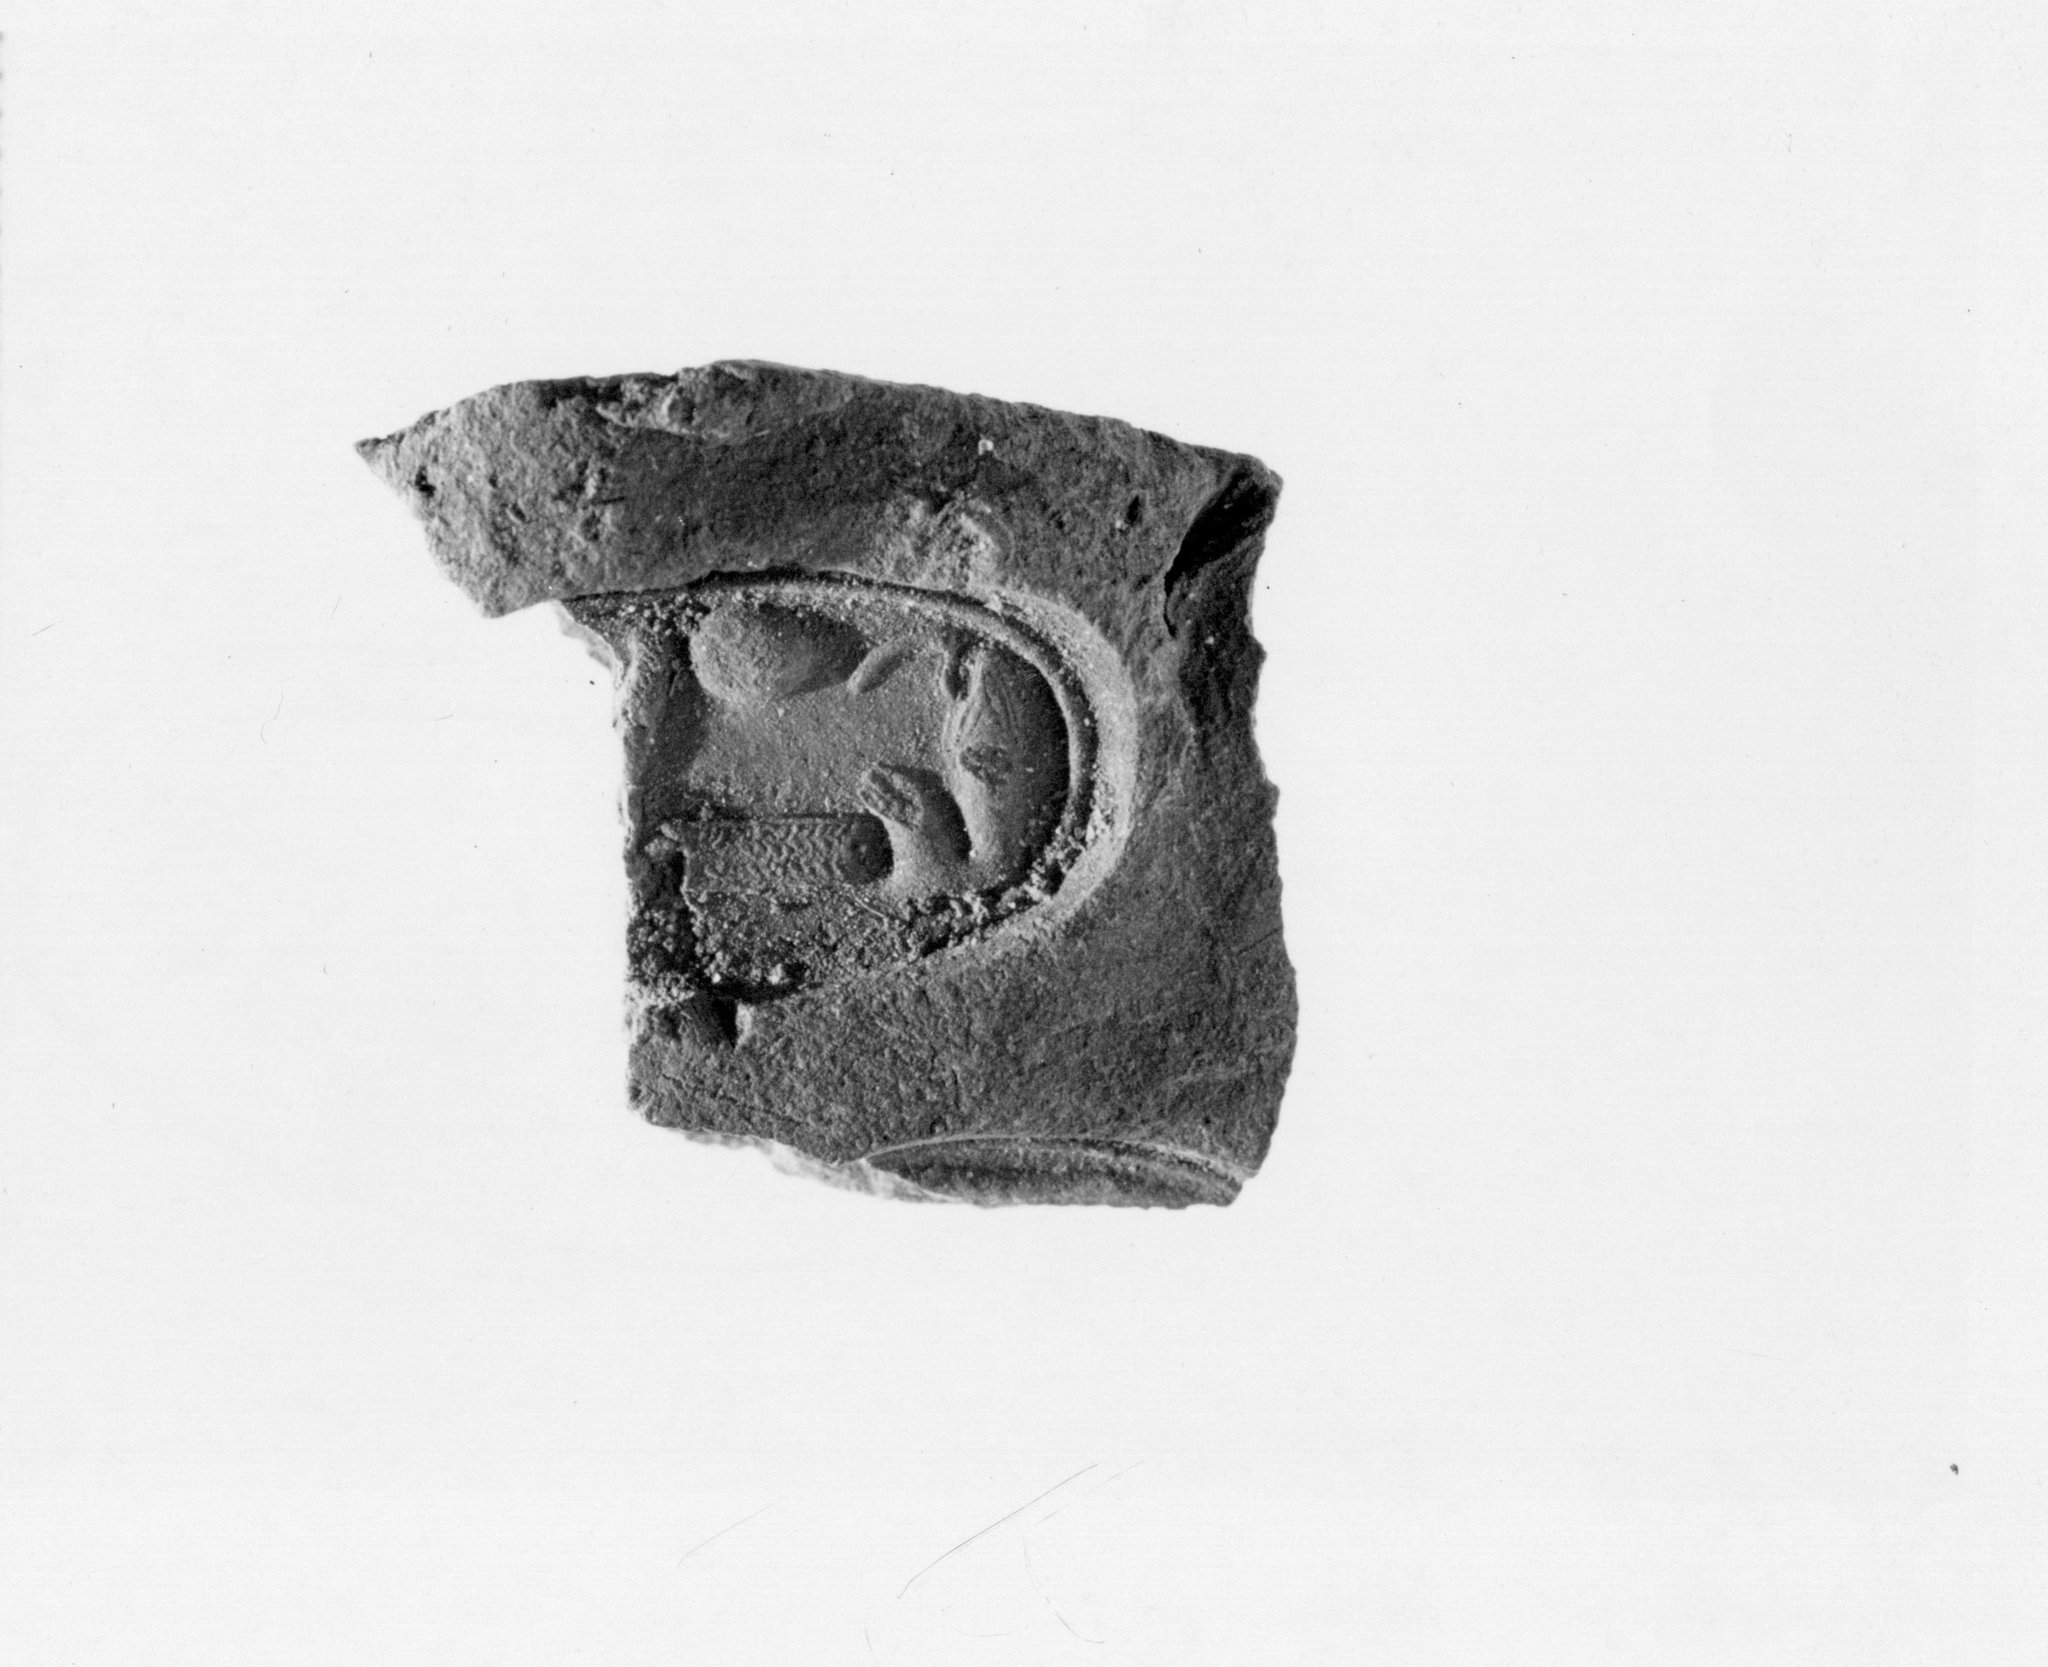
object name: sealing, nebmaatre, amenhotep iii, heb sed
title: Document Sealing With the Throne Name of Amenhotep III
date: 1390-1352 BCE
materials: mud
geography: egypt